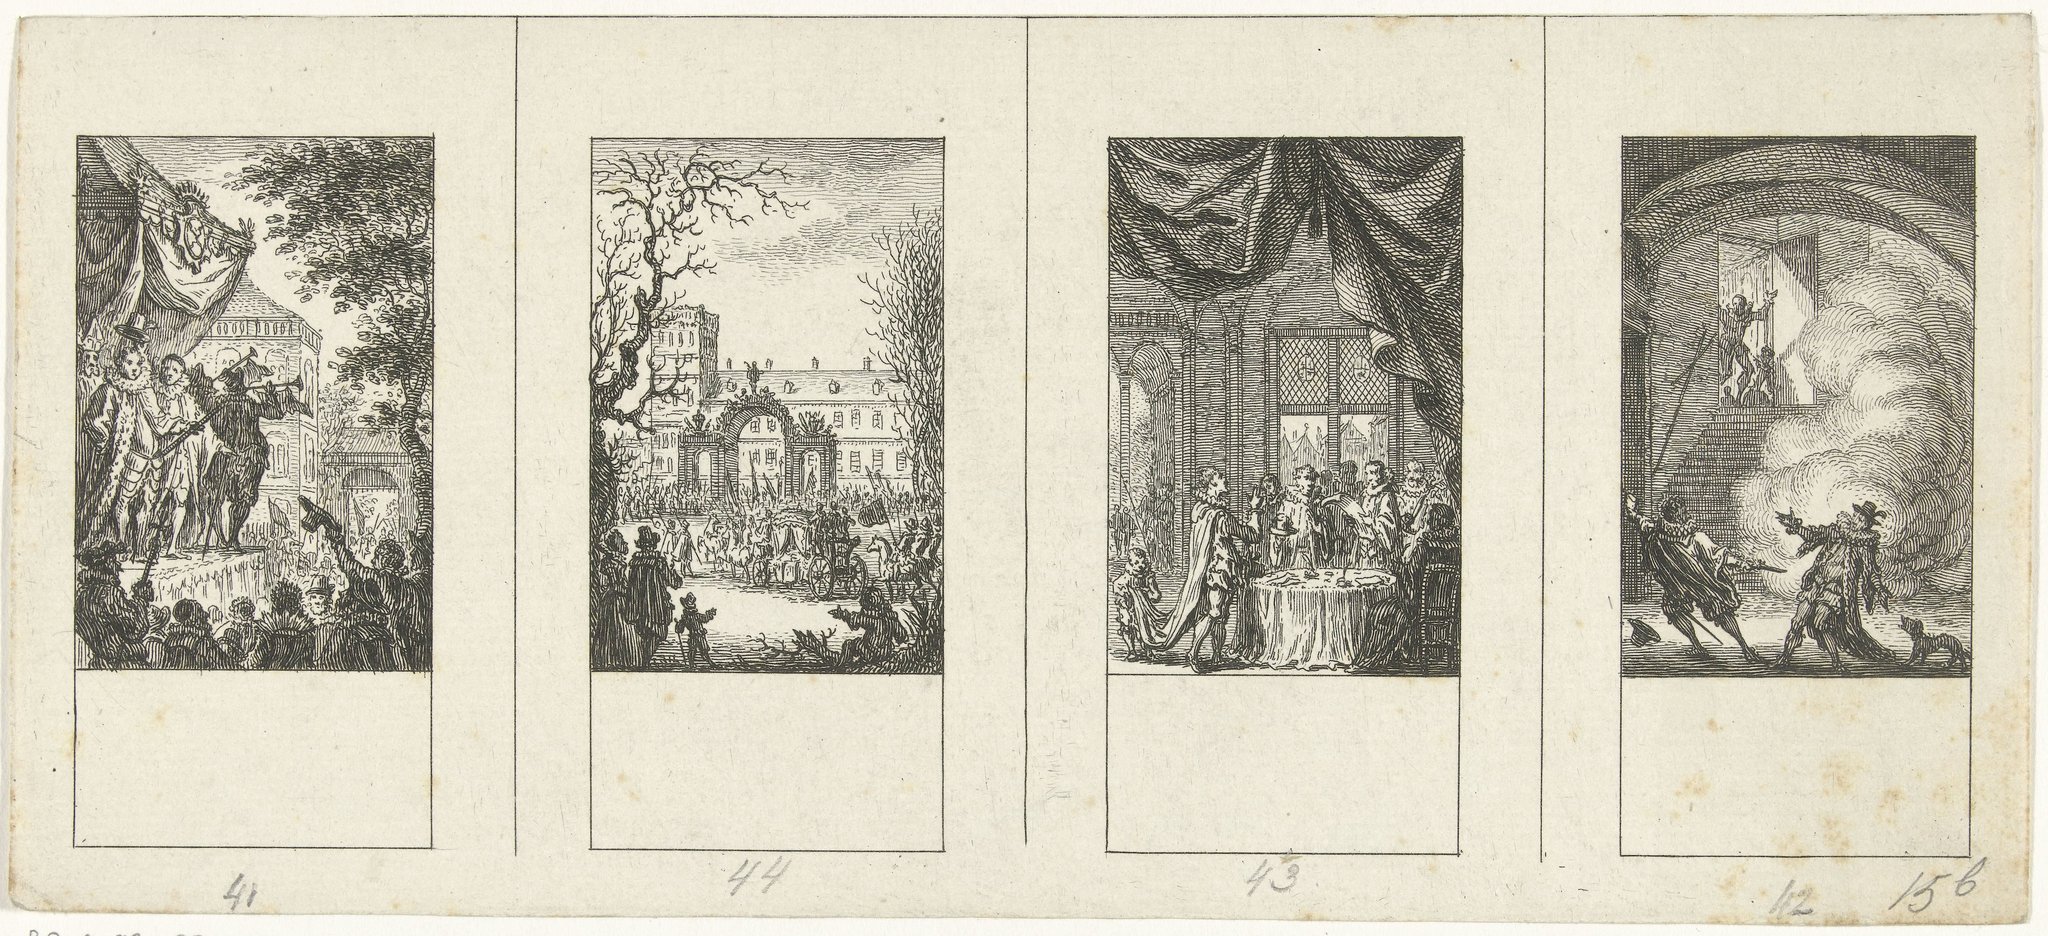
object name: print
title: Illustraties vaderlandse geschiedenis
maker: simon fokke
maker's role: draughtsman, print maker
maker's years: 1712-1784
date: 1722-1784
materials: paper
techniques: etching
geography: amsterdam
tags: delft, william i (prince of orange), the hague, maurice (prince of orange), françois-hercule de valois (hertog van anjou), robert dudley (1st earl of leicester), historical events and situations, historical persons (portraits and scenes from the life)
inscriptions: number: ‘41, 44, 43, 42’, collector's mark: Lugt 2228